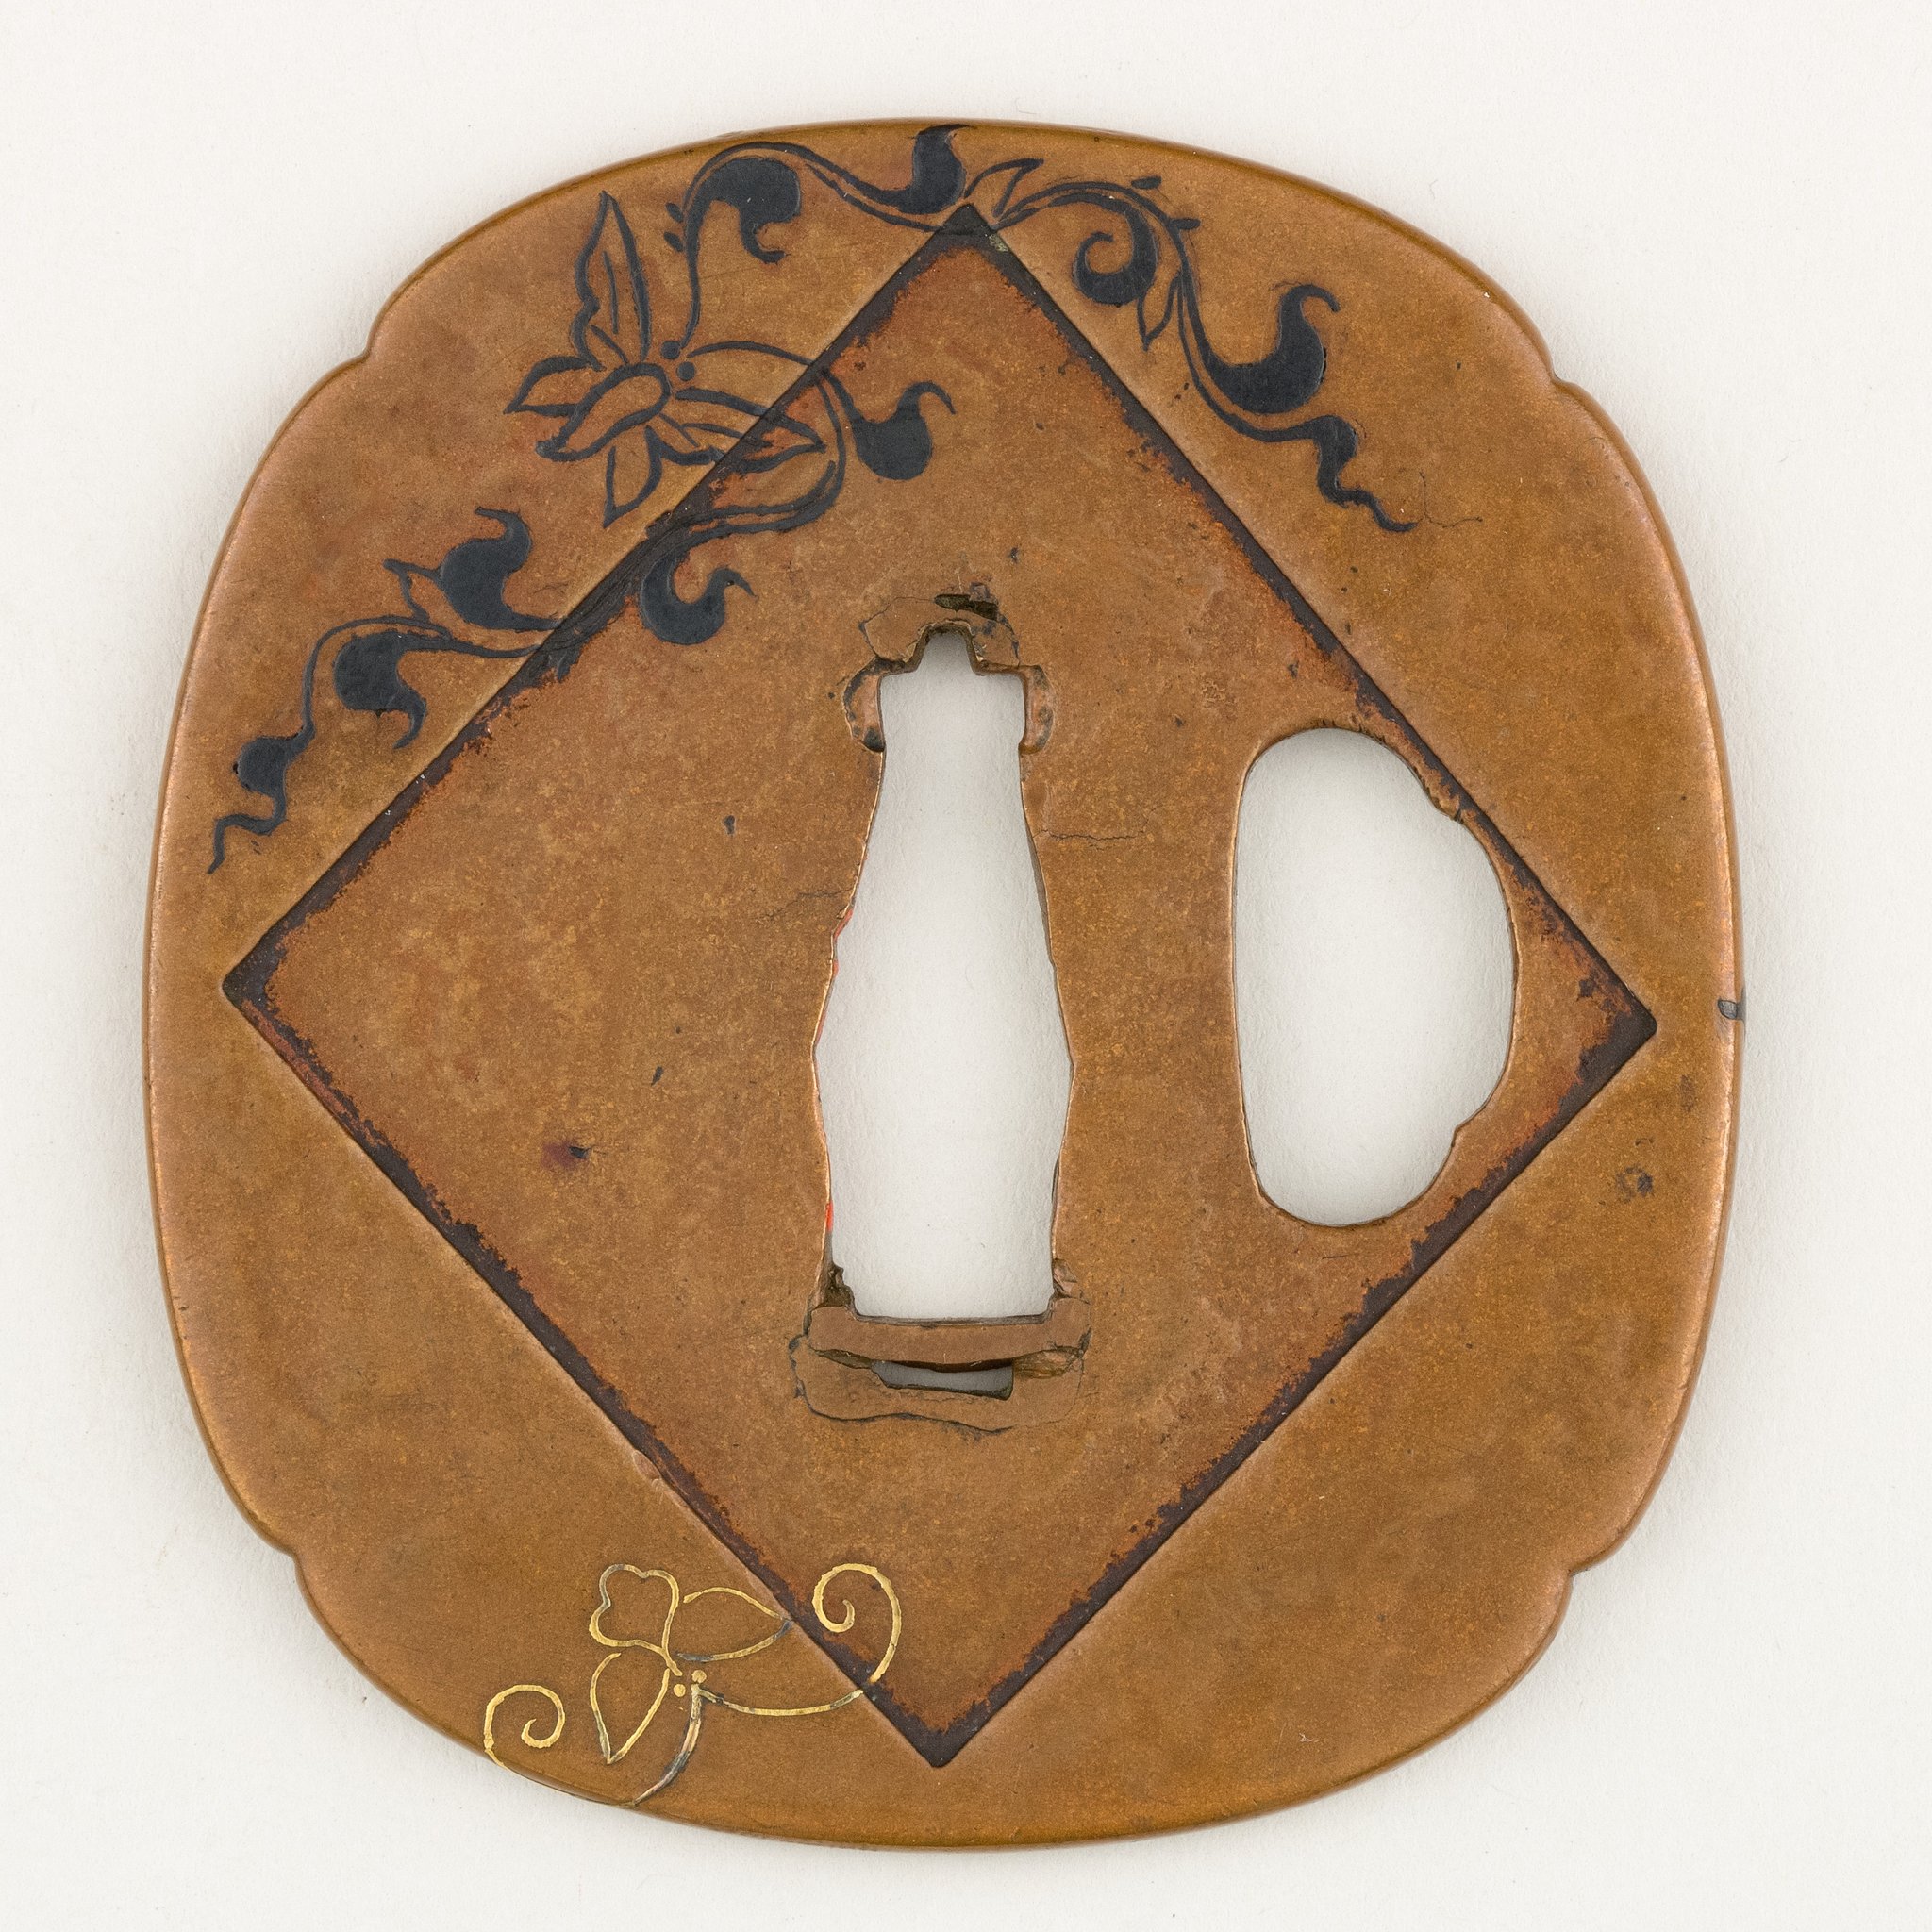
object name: sword guard tsuba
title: Sword Guard (Tsuba)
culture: japanese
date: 1601-1700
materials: copper, gold alloy, gold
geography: japan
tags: butterflies